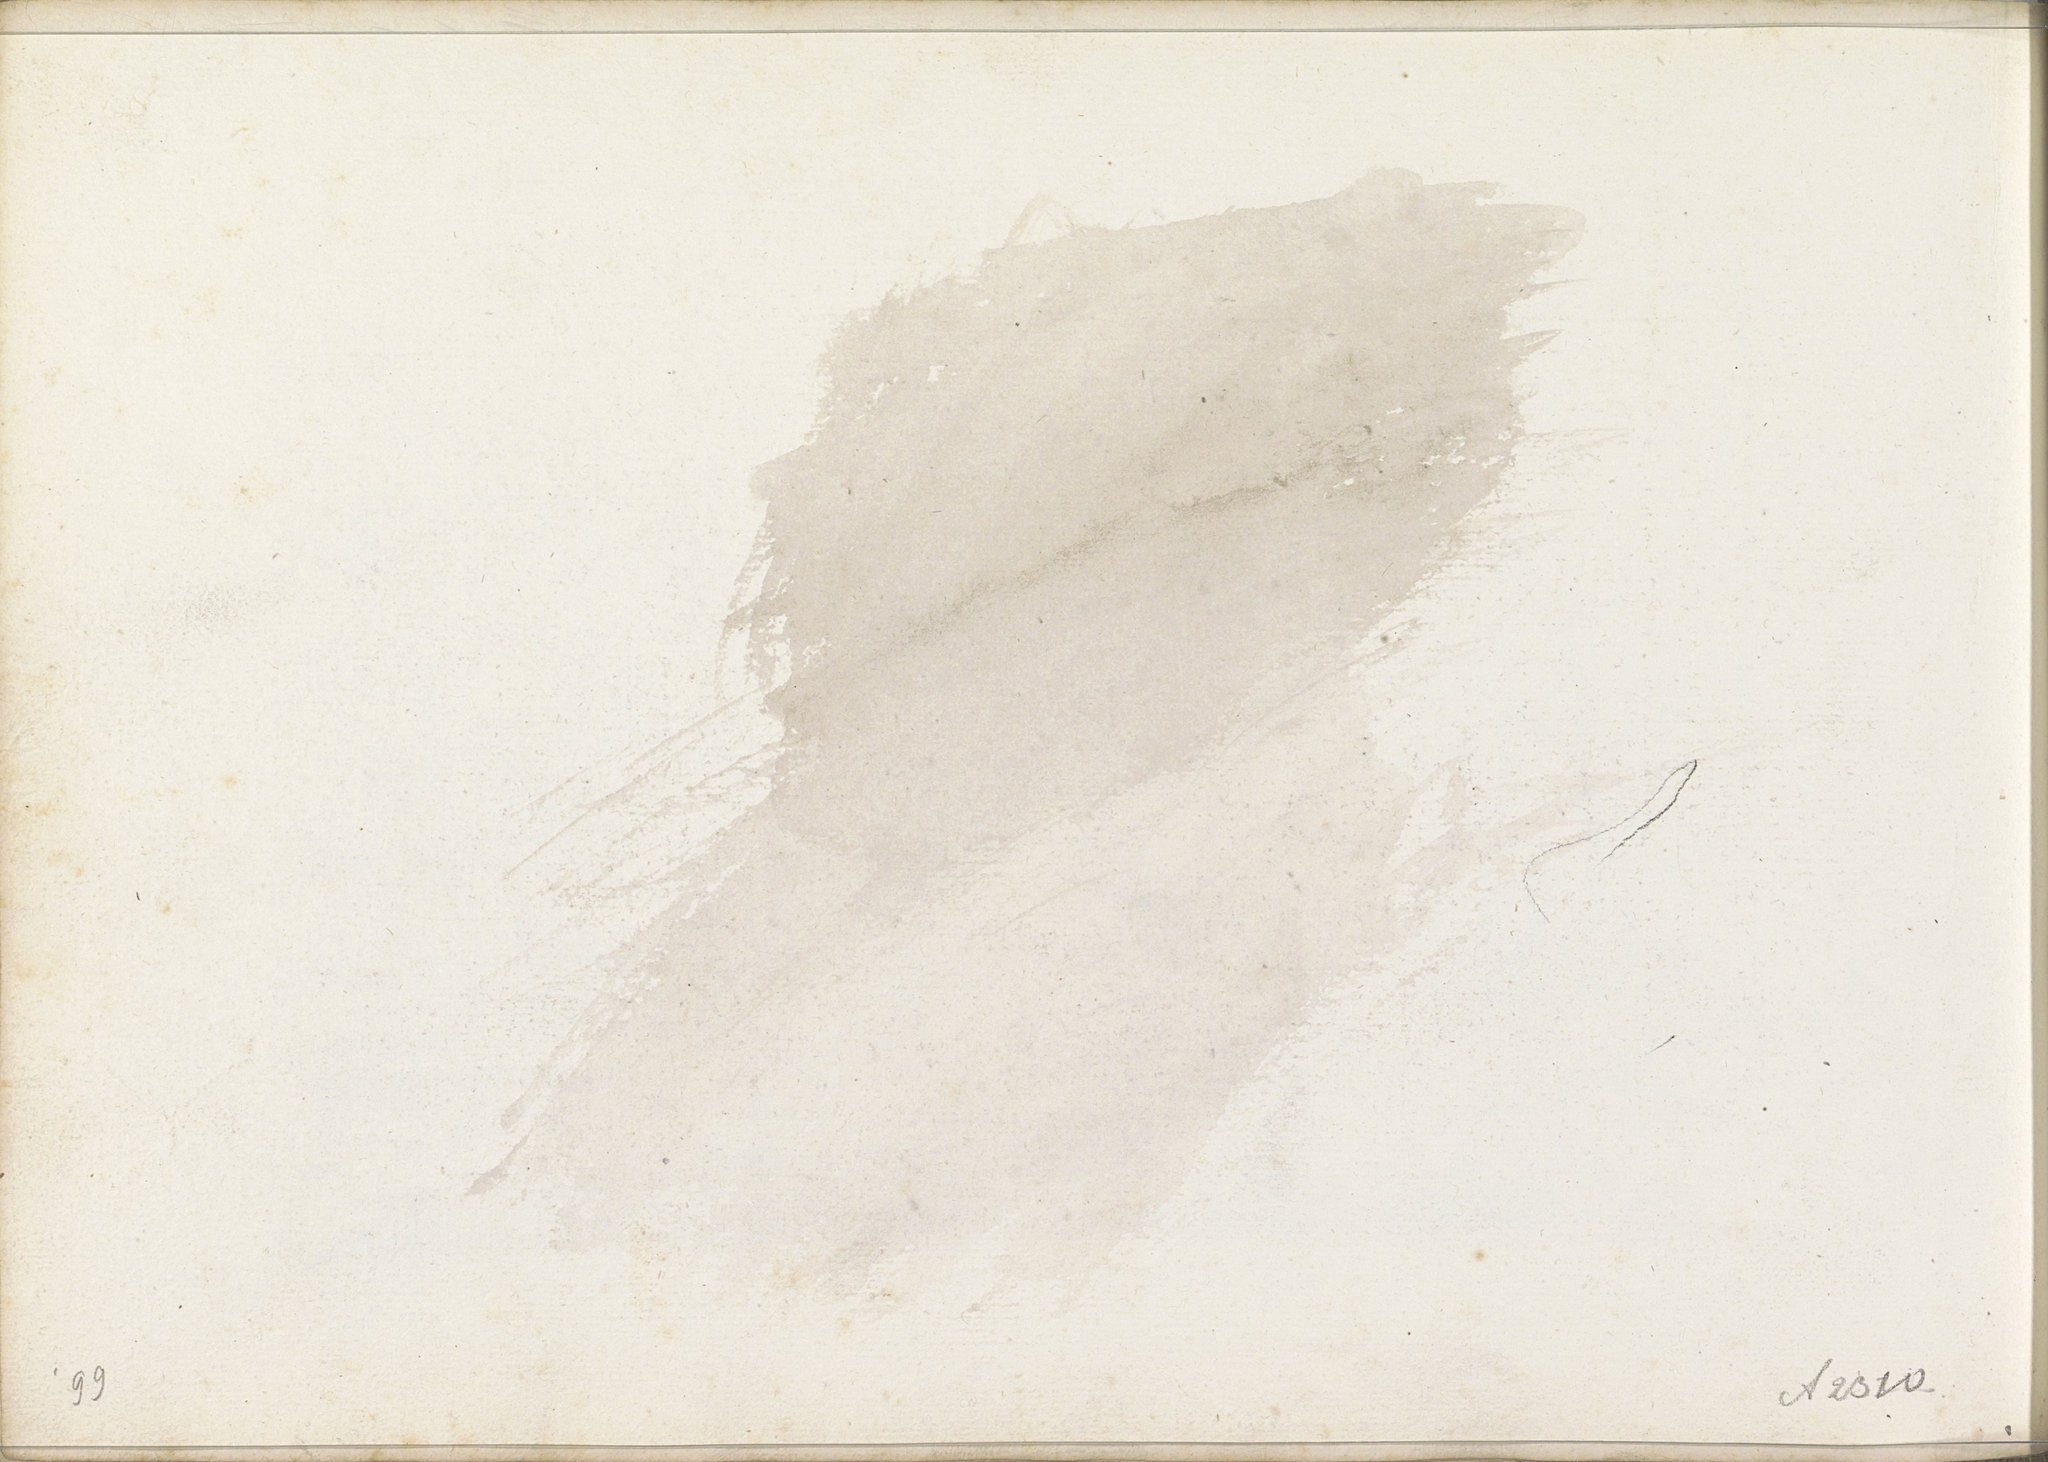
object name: sketchbook leaf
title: Studie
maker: andreas schelfhout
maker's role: draughtsman, painter, print maker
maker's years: 1787-1870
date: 1811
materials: paper, watercolor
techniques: brush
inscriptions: annotation: ‘'99/ A2310’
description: Blad 59 verso uit een schetsboek met 75 bladen.